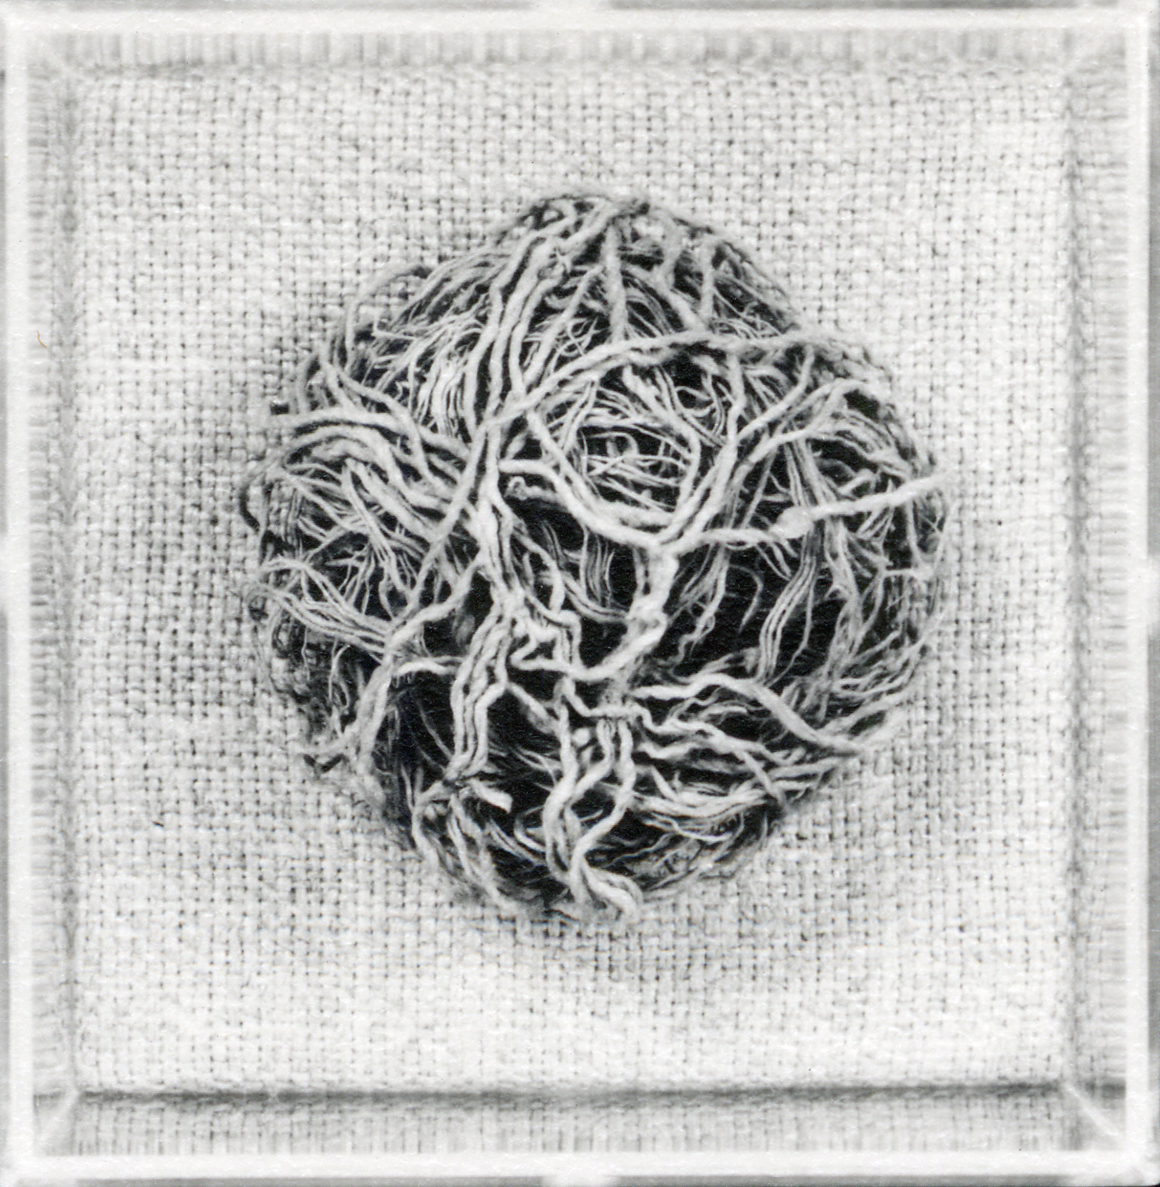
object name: ball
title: Ball Net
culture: coptic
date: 301-400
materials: linen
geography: egypt